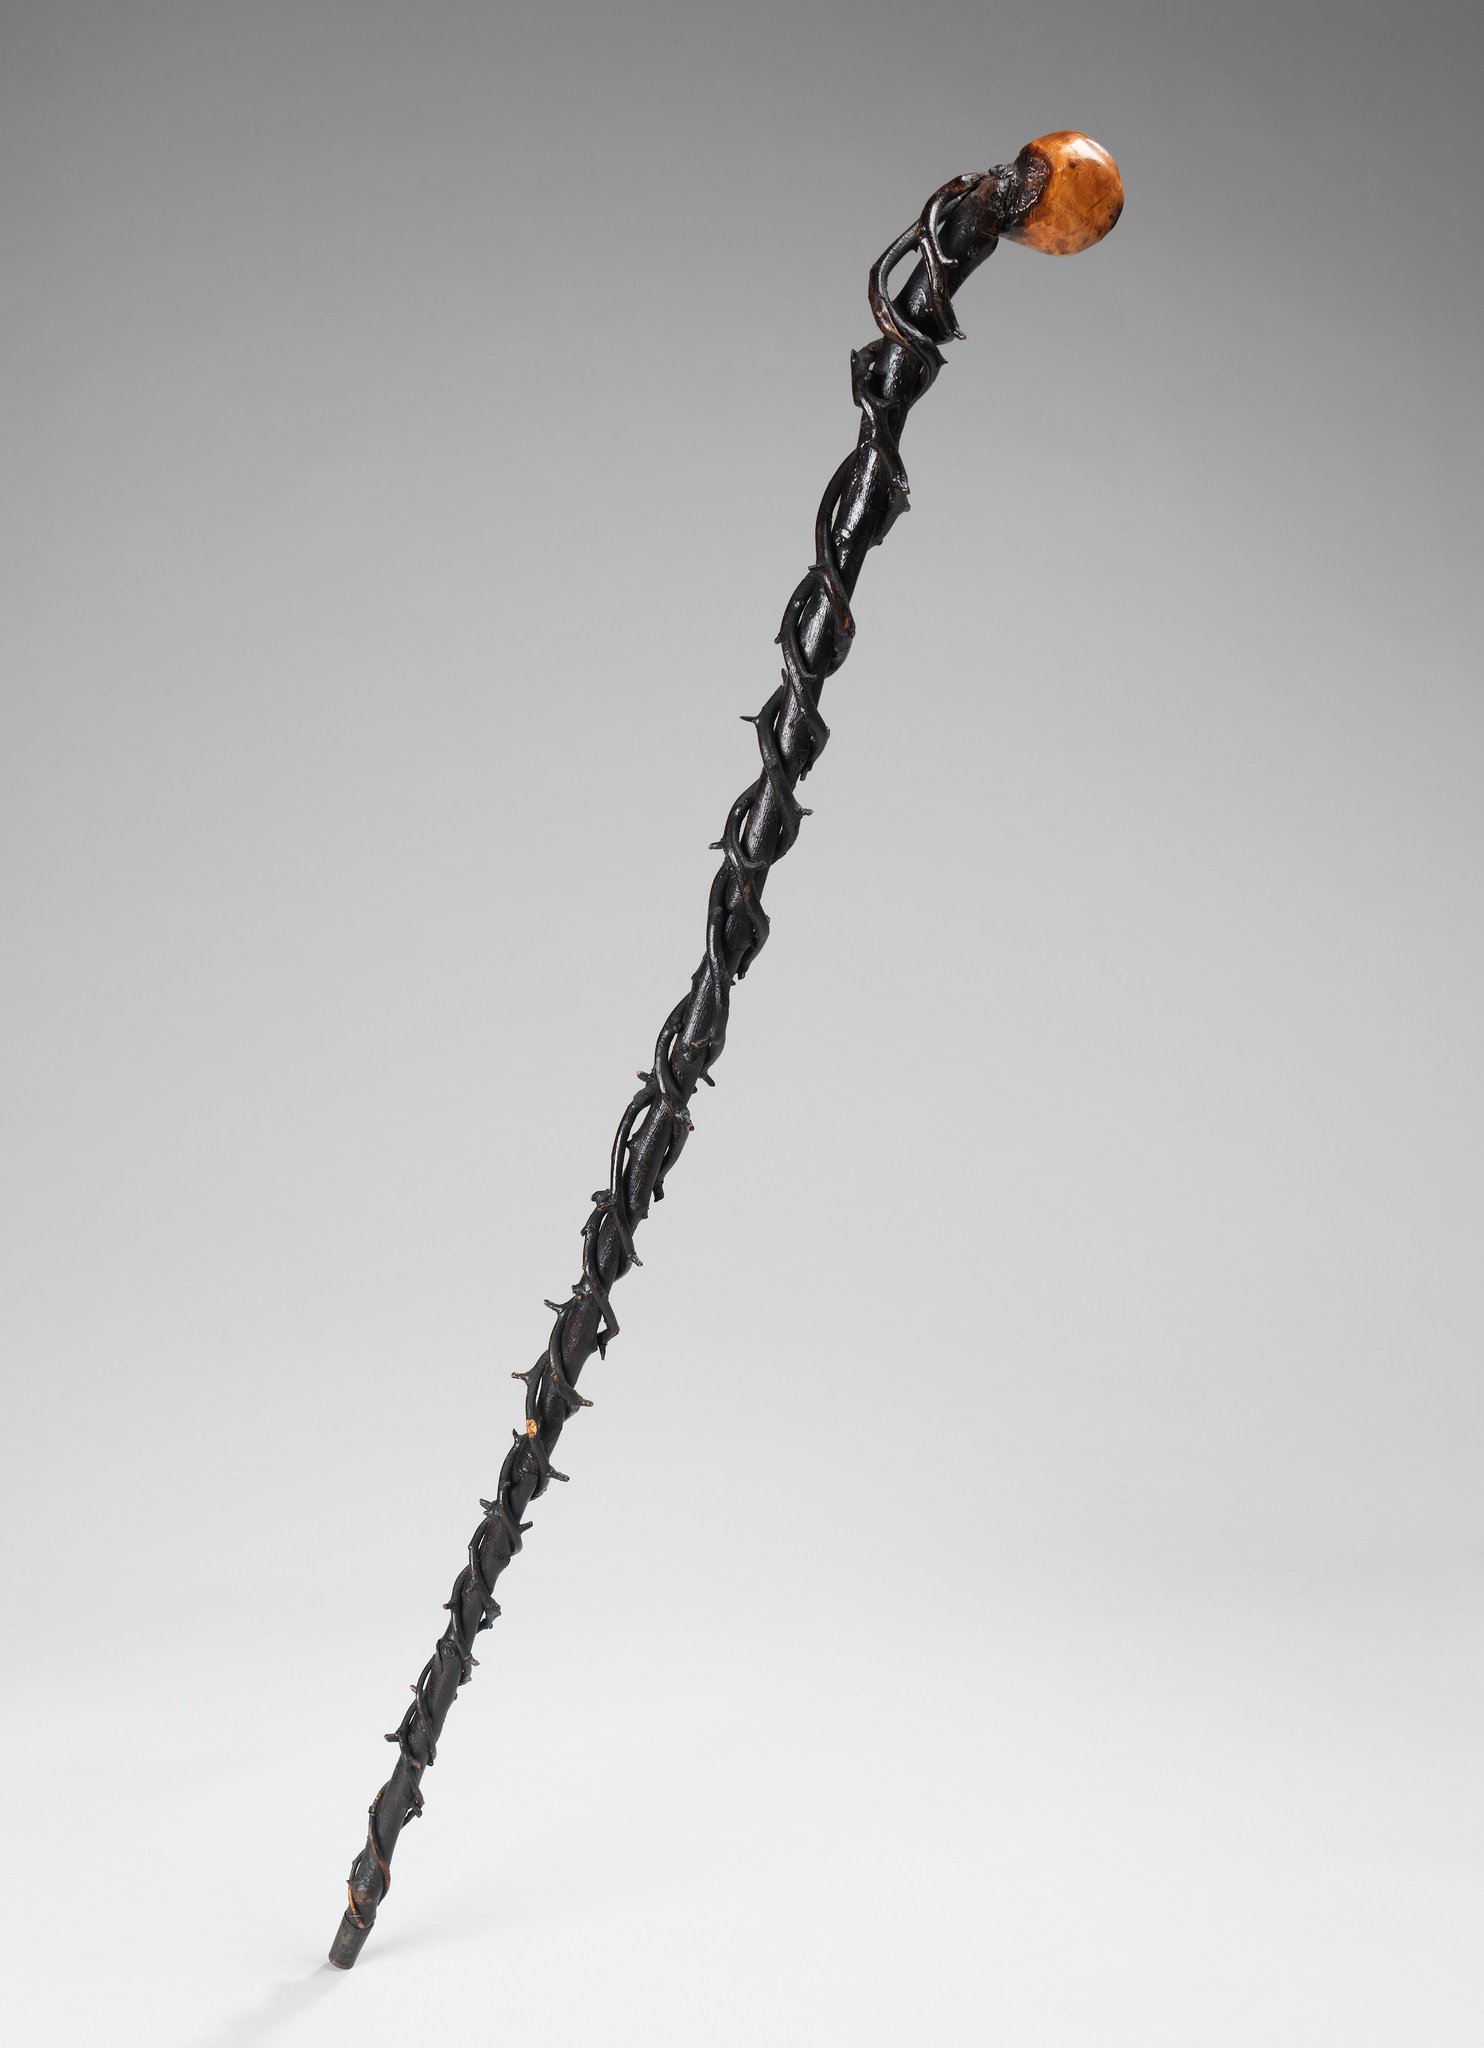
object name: cane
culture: irish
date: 1867-1900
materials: metal, wood